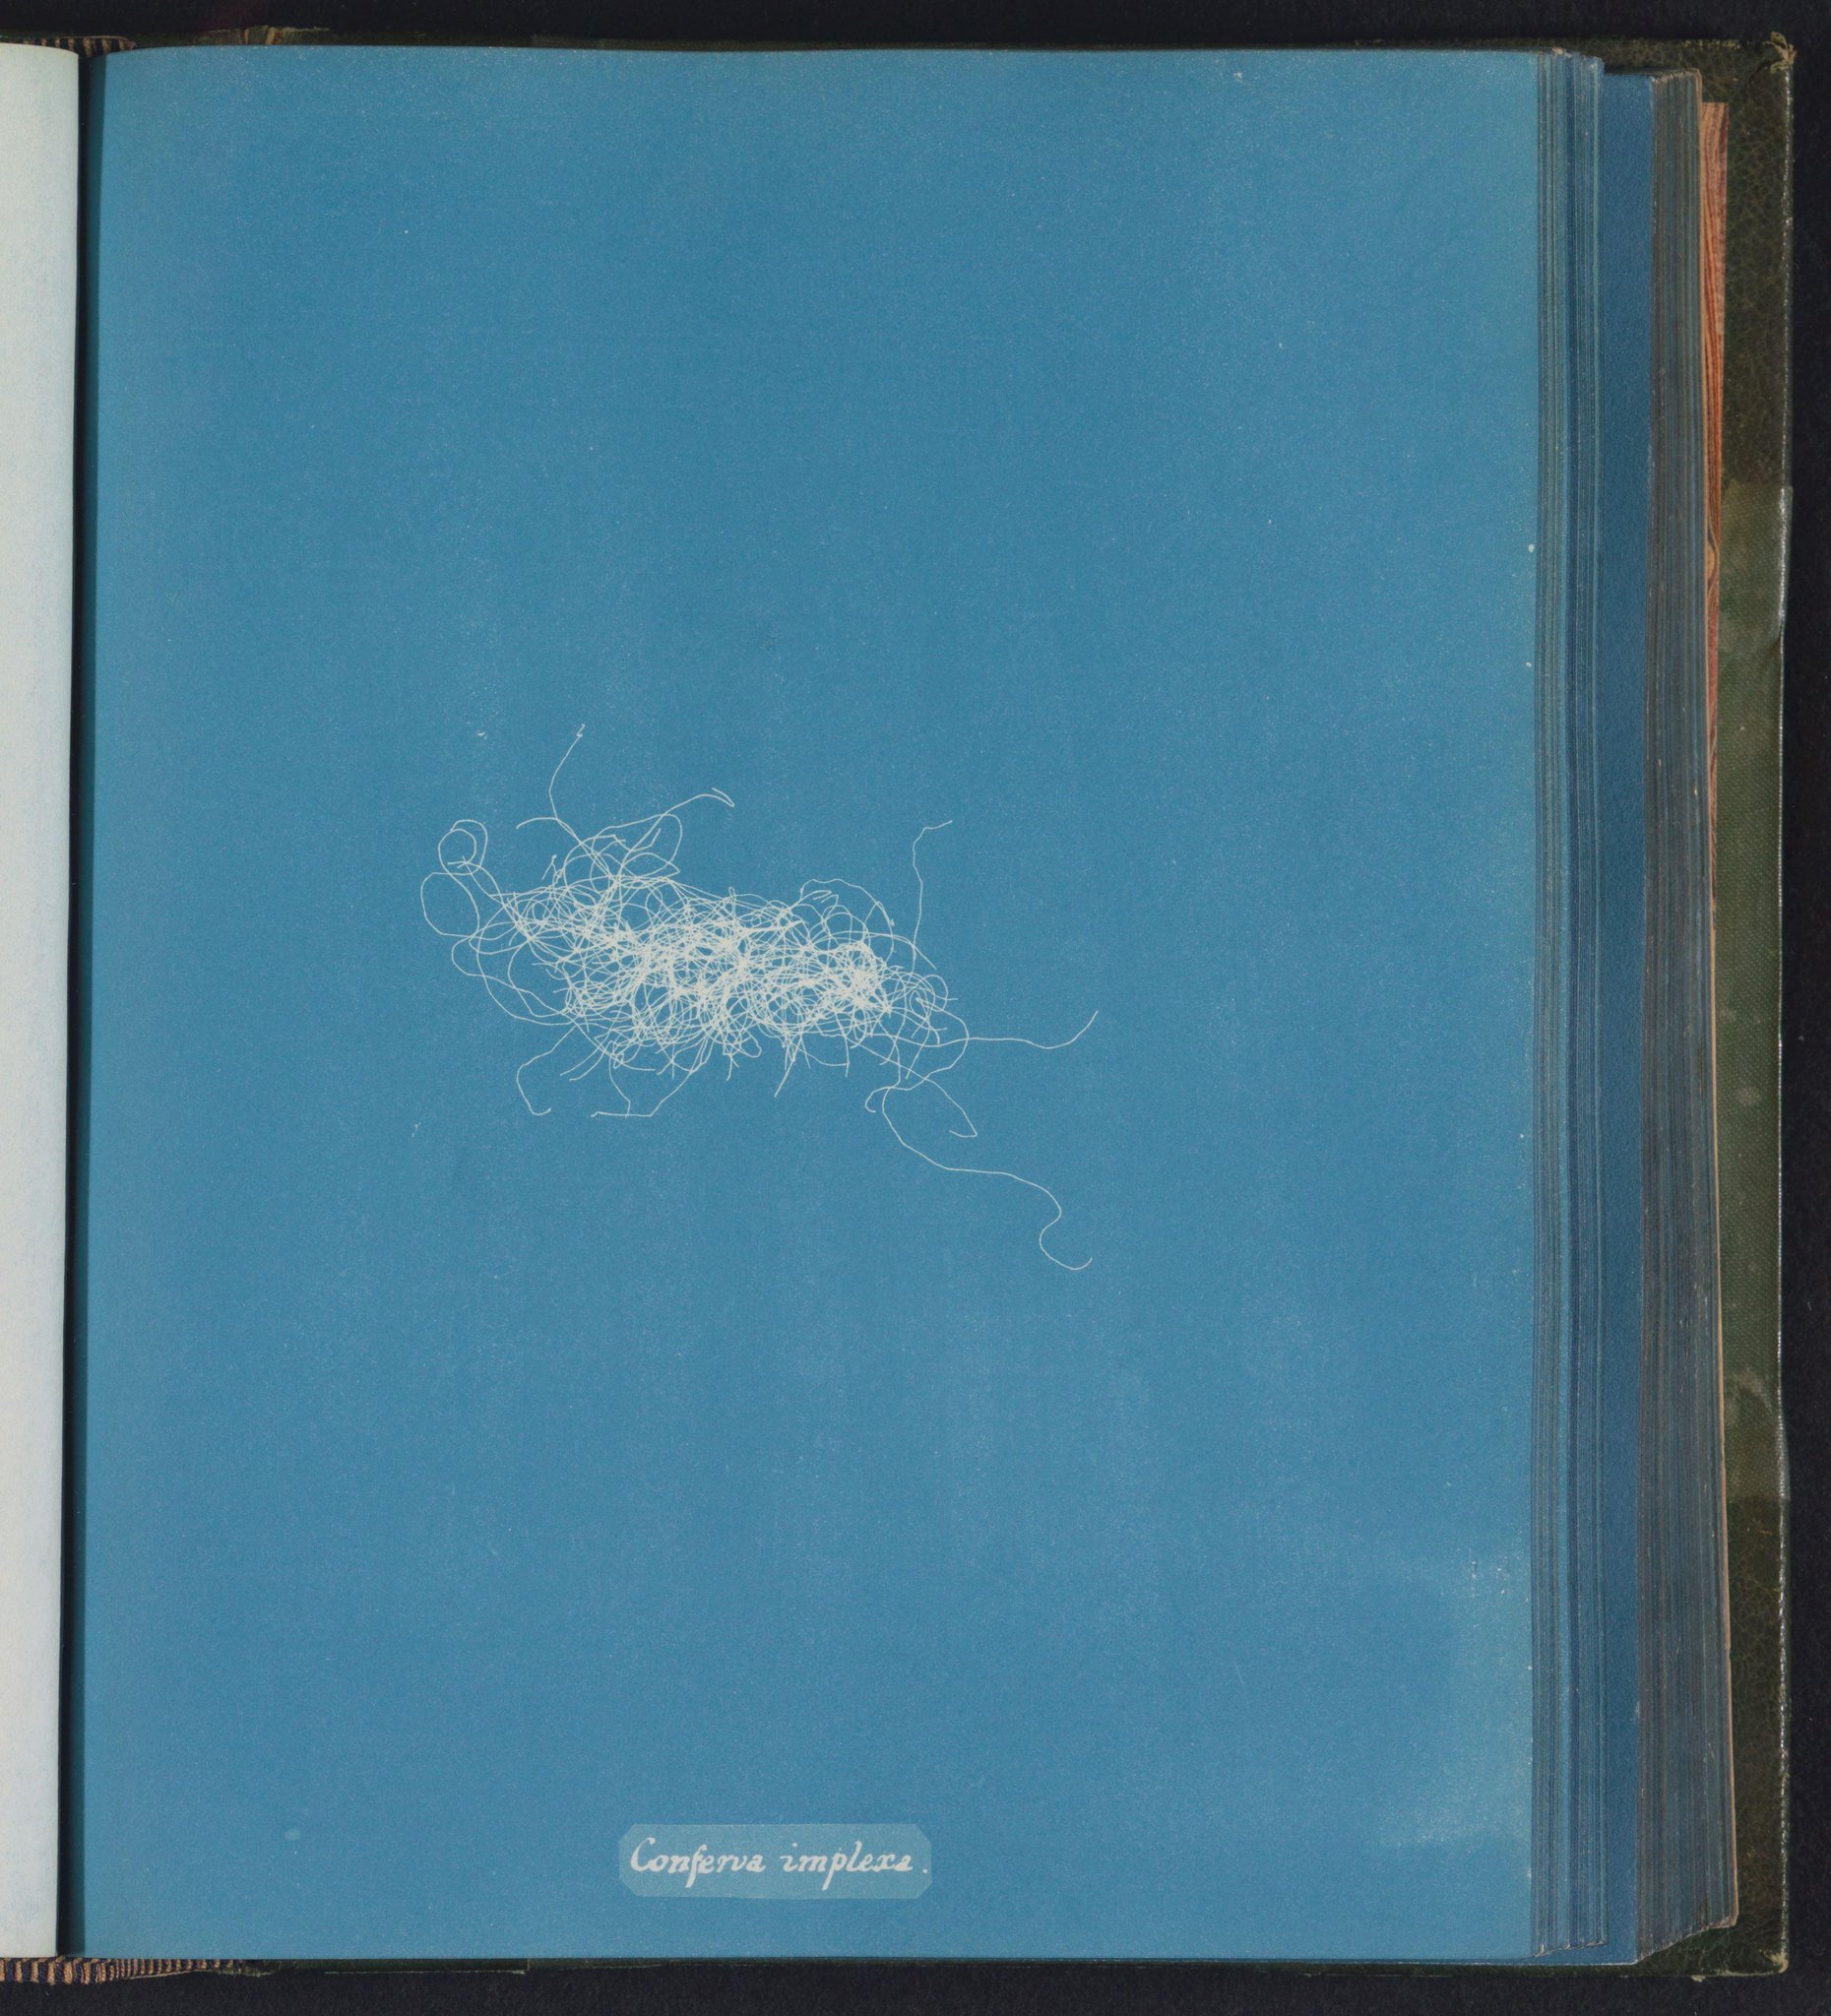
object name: page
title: Conferva implexa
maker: anna atkins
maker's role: fotograaf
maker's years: 1799-1871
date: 1843-1853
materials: photographic support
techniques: cyanotype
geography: united kingdom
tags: algae, seaweed